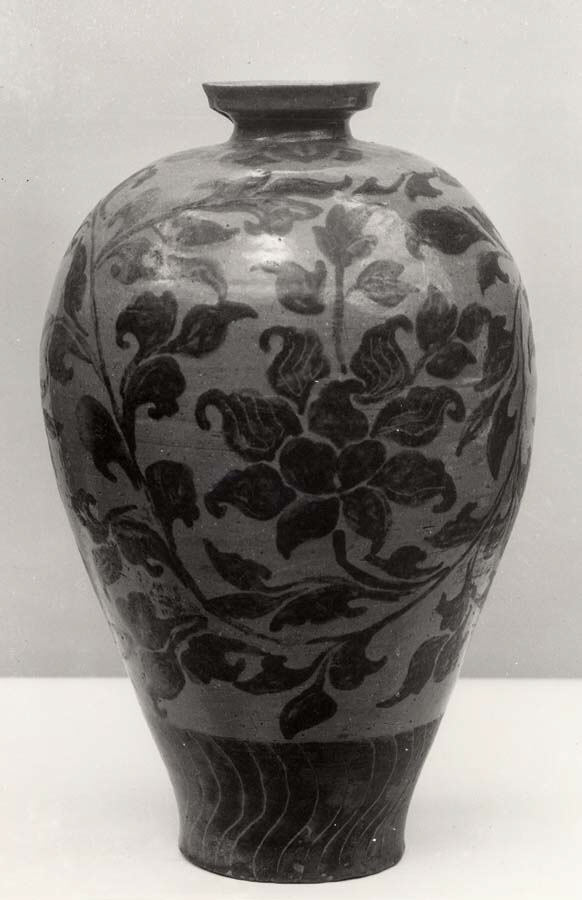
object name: vase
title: Maebyeong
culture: korean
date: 1101-1200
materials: ceramic glaze, glaze, iron, stoneware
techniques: underglaze